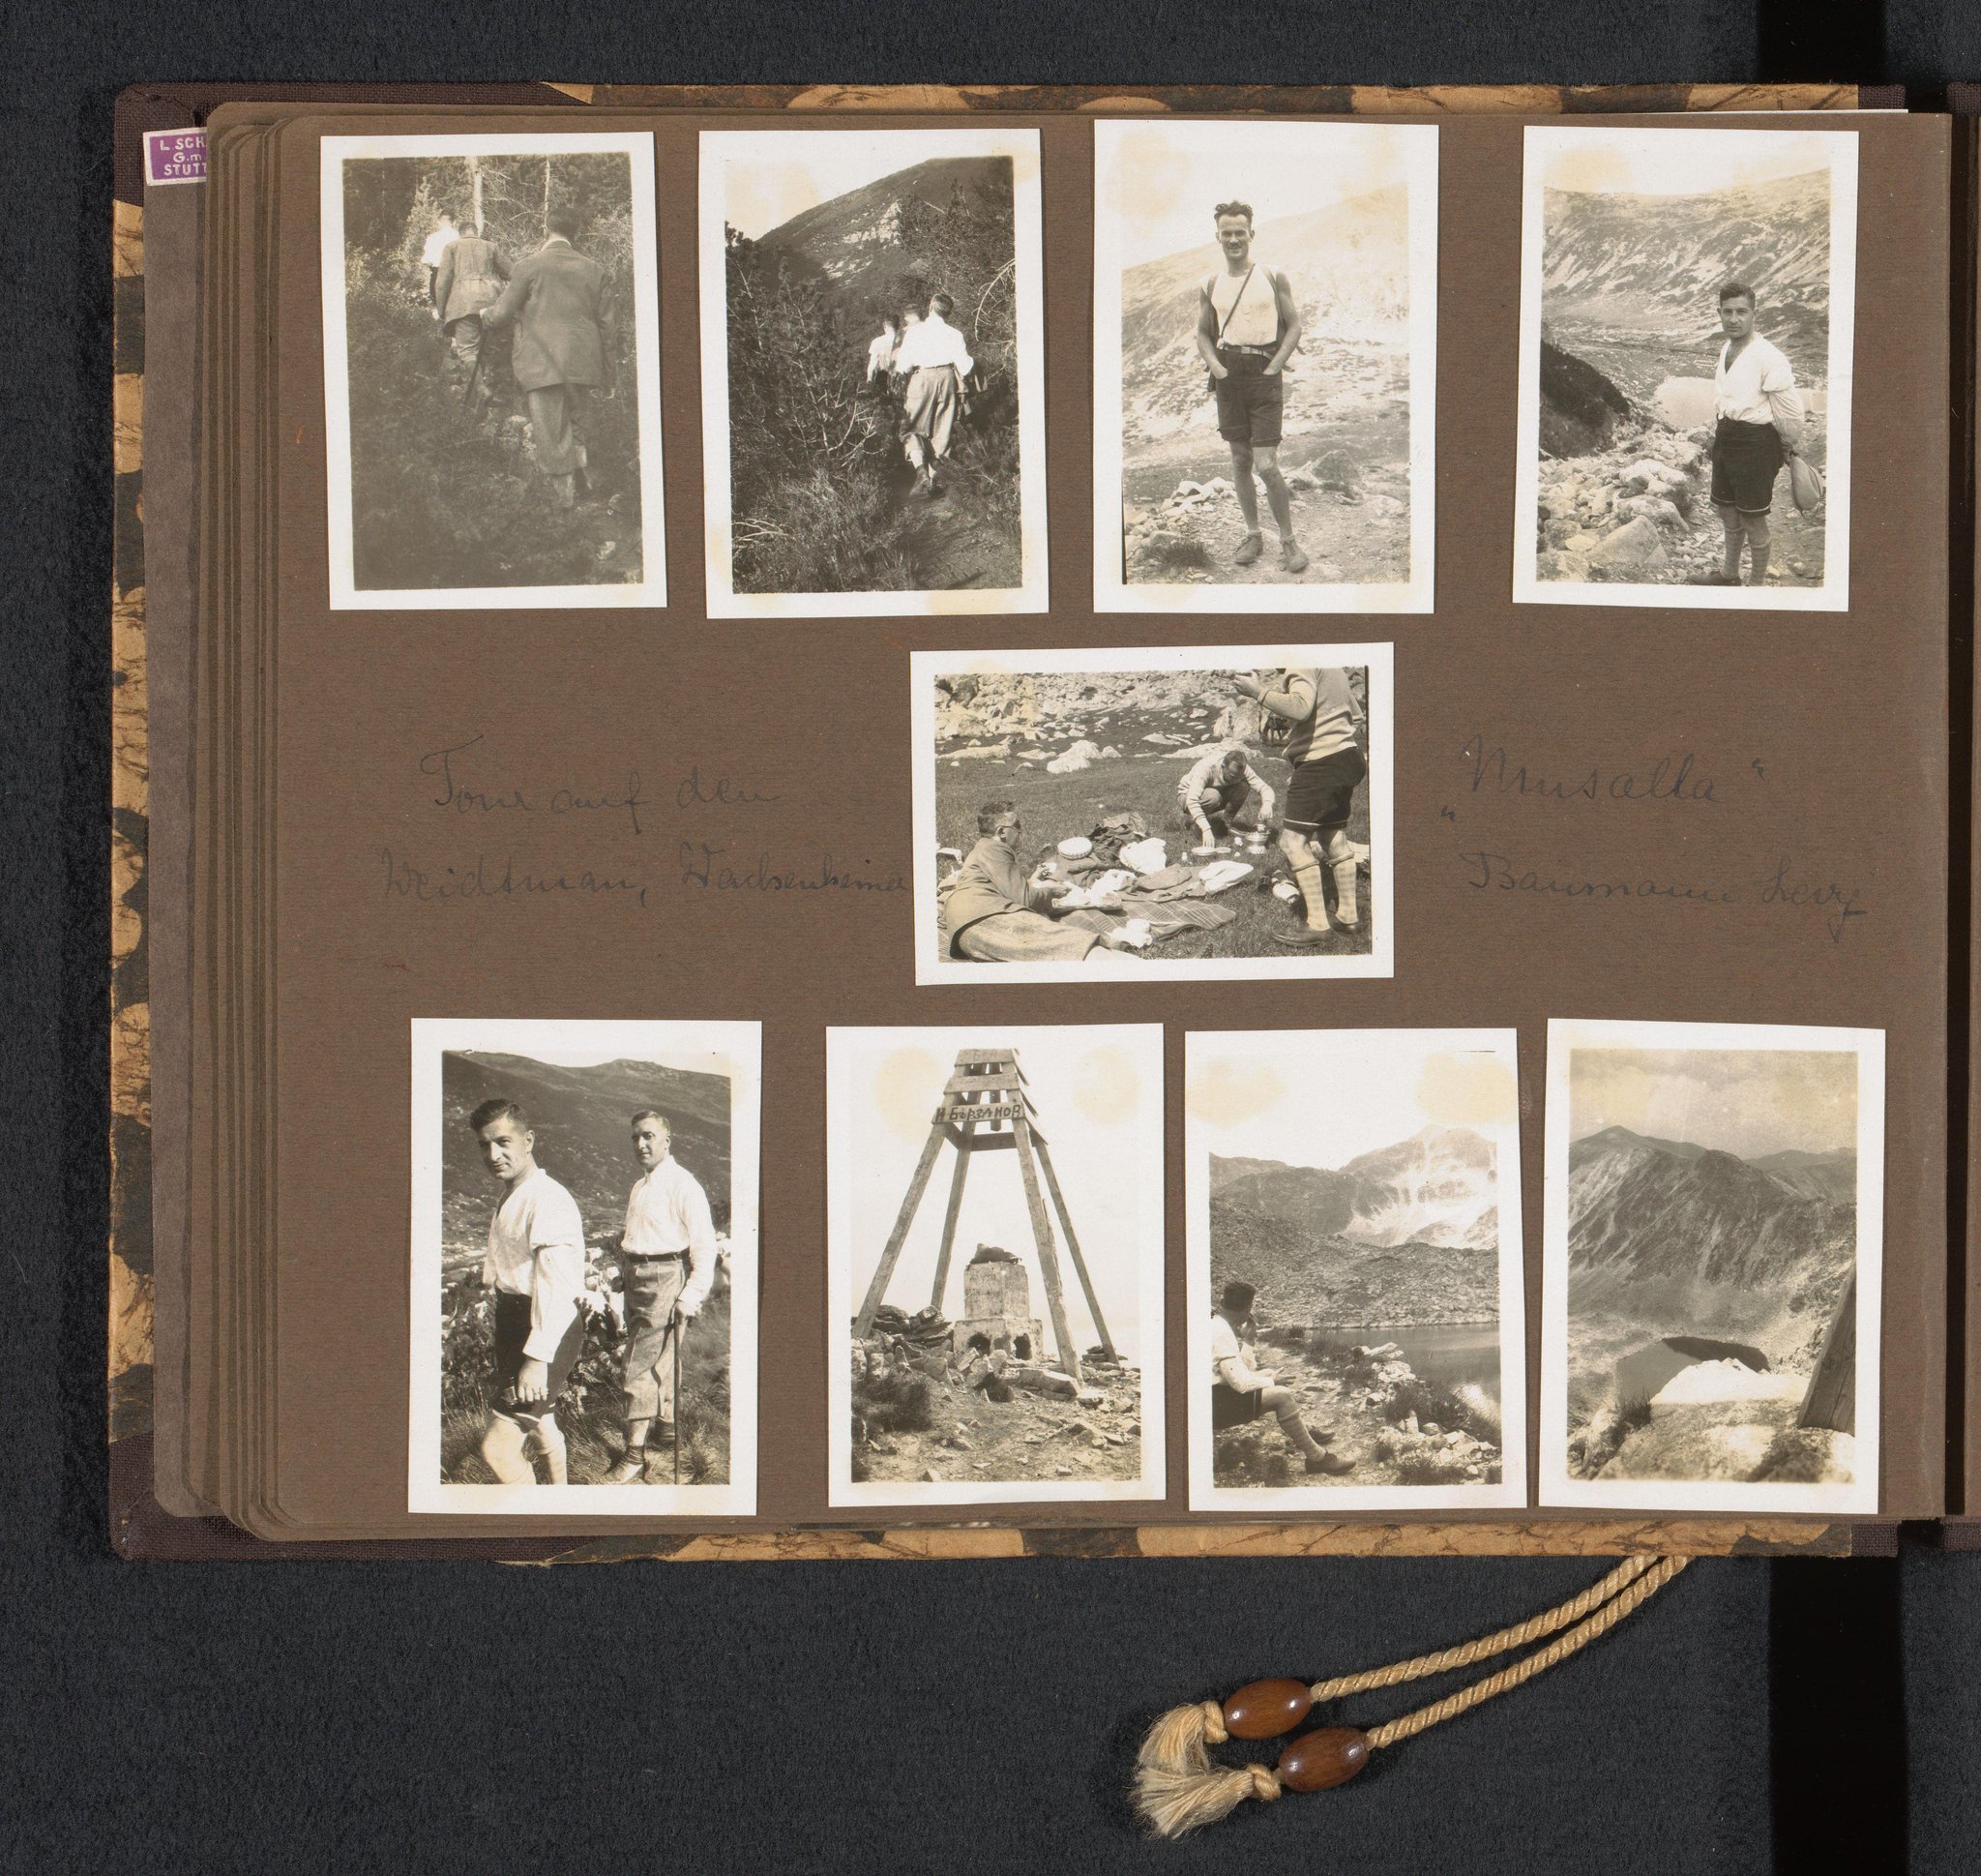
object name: album leaf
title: Eugen Wachenheimer in de Bulgaarse natuur met onbekende mannen, tijdens een rondreis van Eugen met zijn echtgenote Else Wachenheimer-Moos door Bulgarije, 1926-1927, Bulgarije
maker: else wachenheimer-moos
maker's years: 1895-1944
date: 1926-1927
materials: paper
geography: bulgaria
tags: eugen wachenheimer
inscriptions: inscription: ‘(onleesbaar) auf den Weidturan, Wachenheimer ,,Musalla" Baumann Levy’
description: Albumblad bevat negen foto's van Eugen Wachenheimer (in lichte bovenkleding) en onbekende mannen. Afkomstig uit album half formaat, kartonomslag met koordbinding en lichte veelvormige vormen op voorzijde.